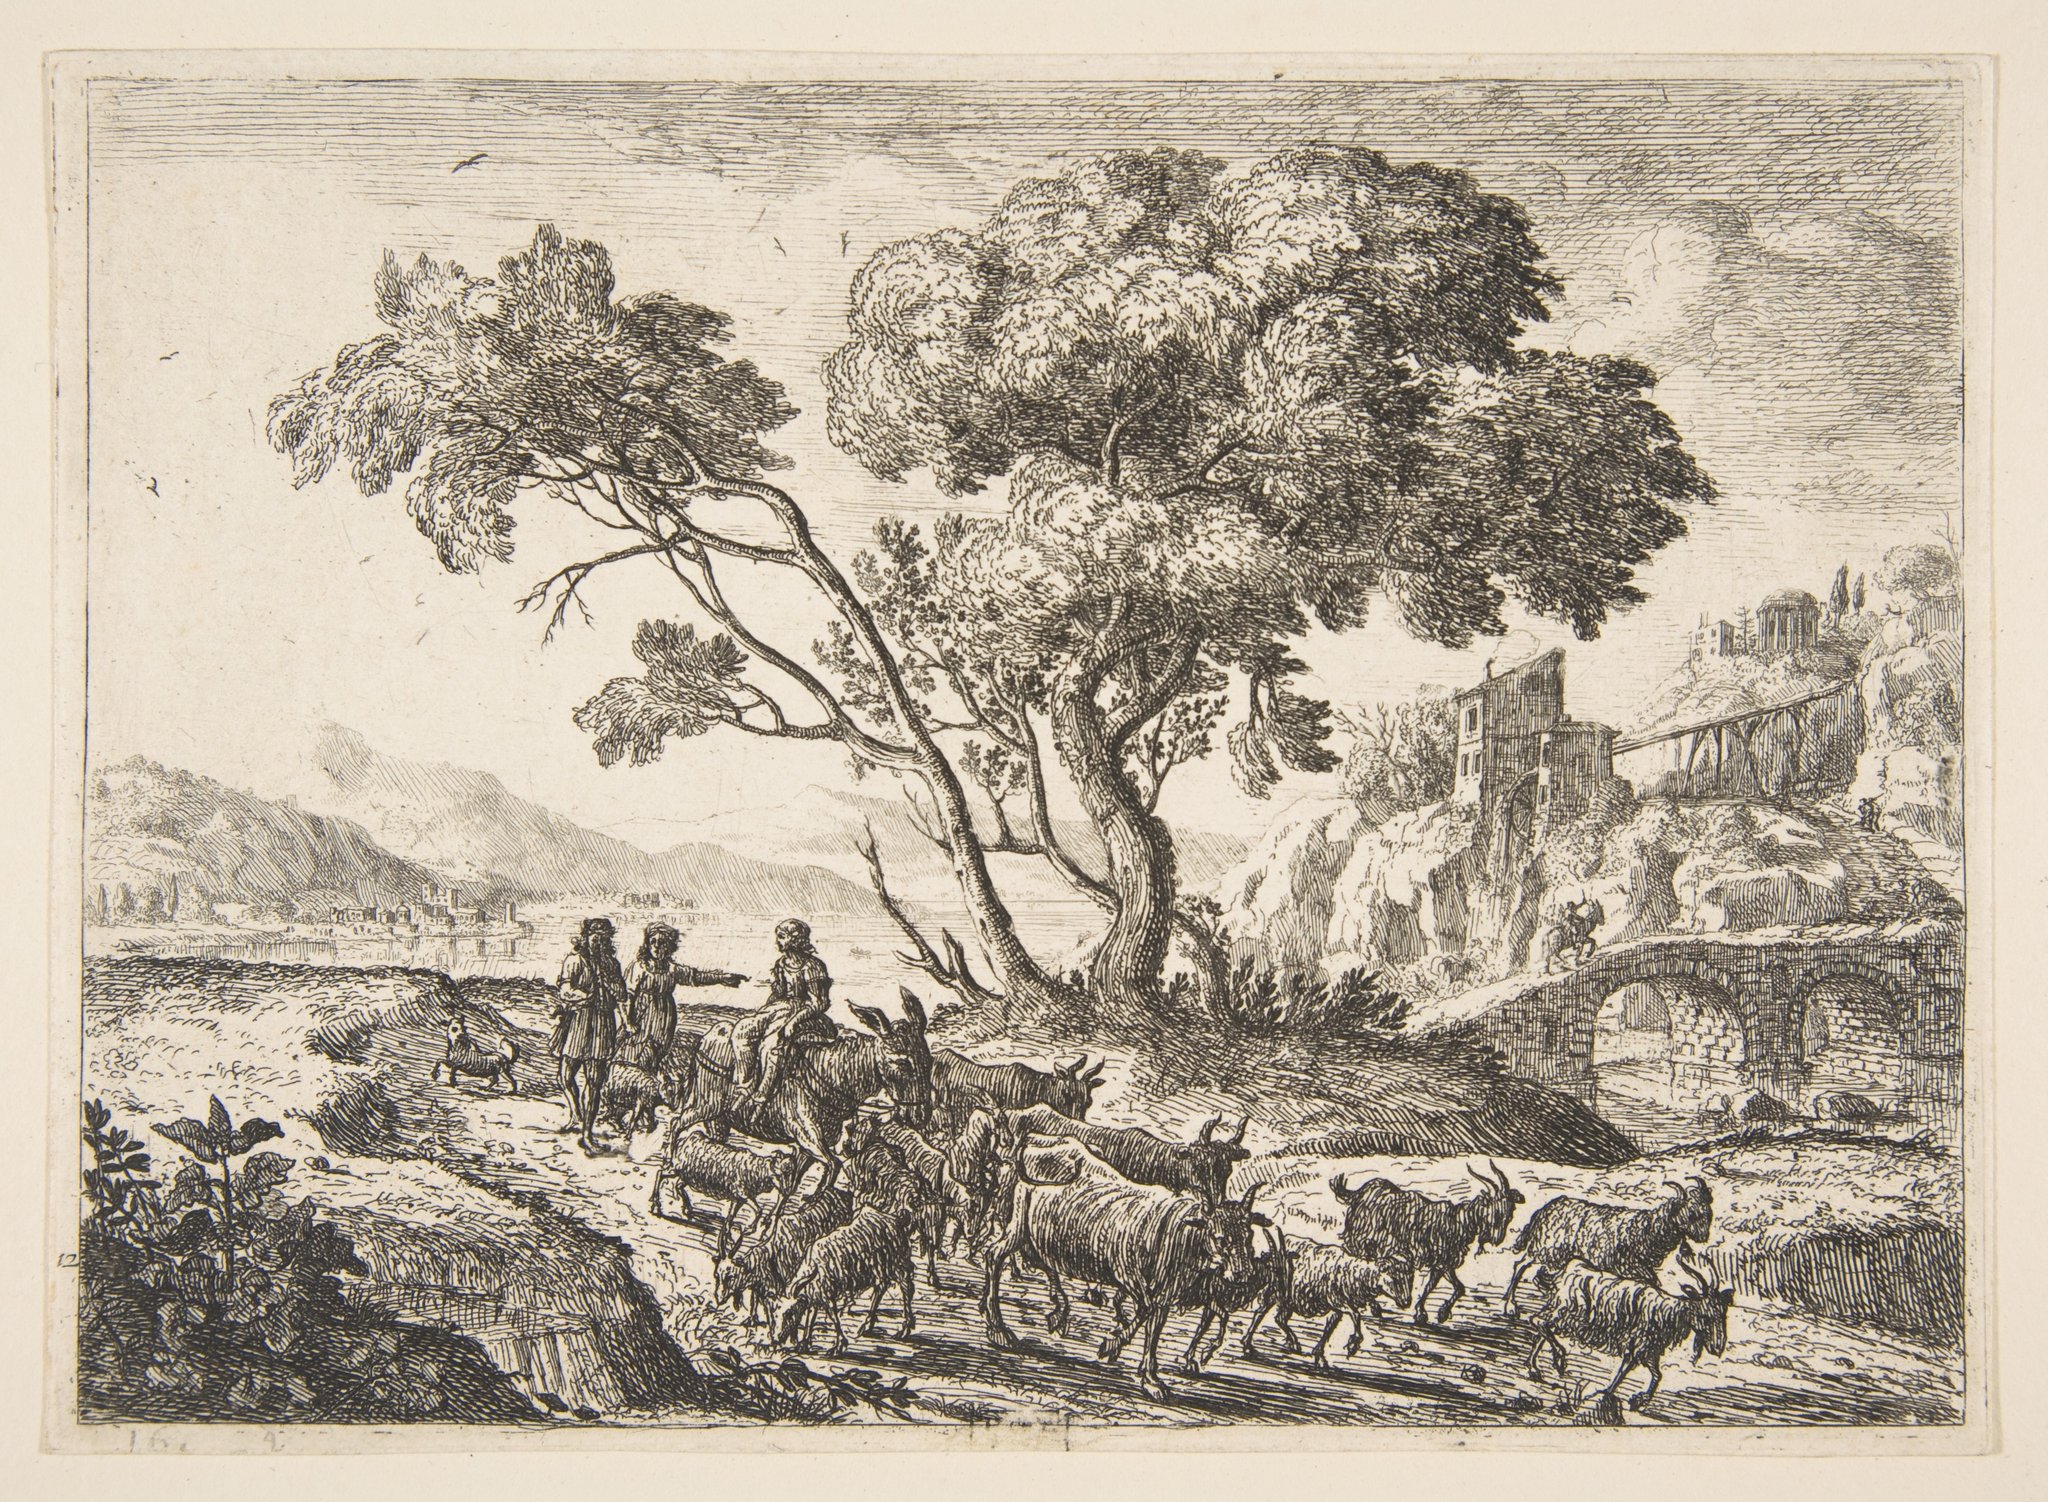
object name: print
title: Departure for the Fields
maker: claude lorrain (claude gellée)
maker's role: artist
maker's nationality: french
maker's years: 1604-1682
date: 1638-1641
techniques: etching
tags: human figures,animals,bridges,trees